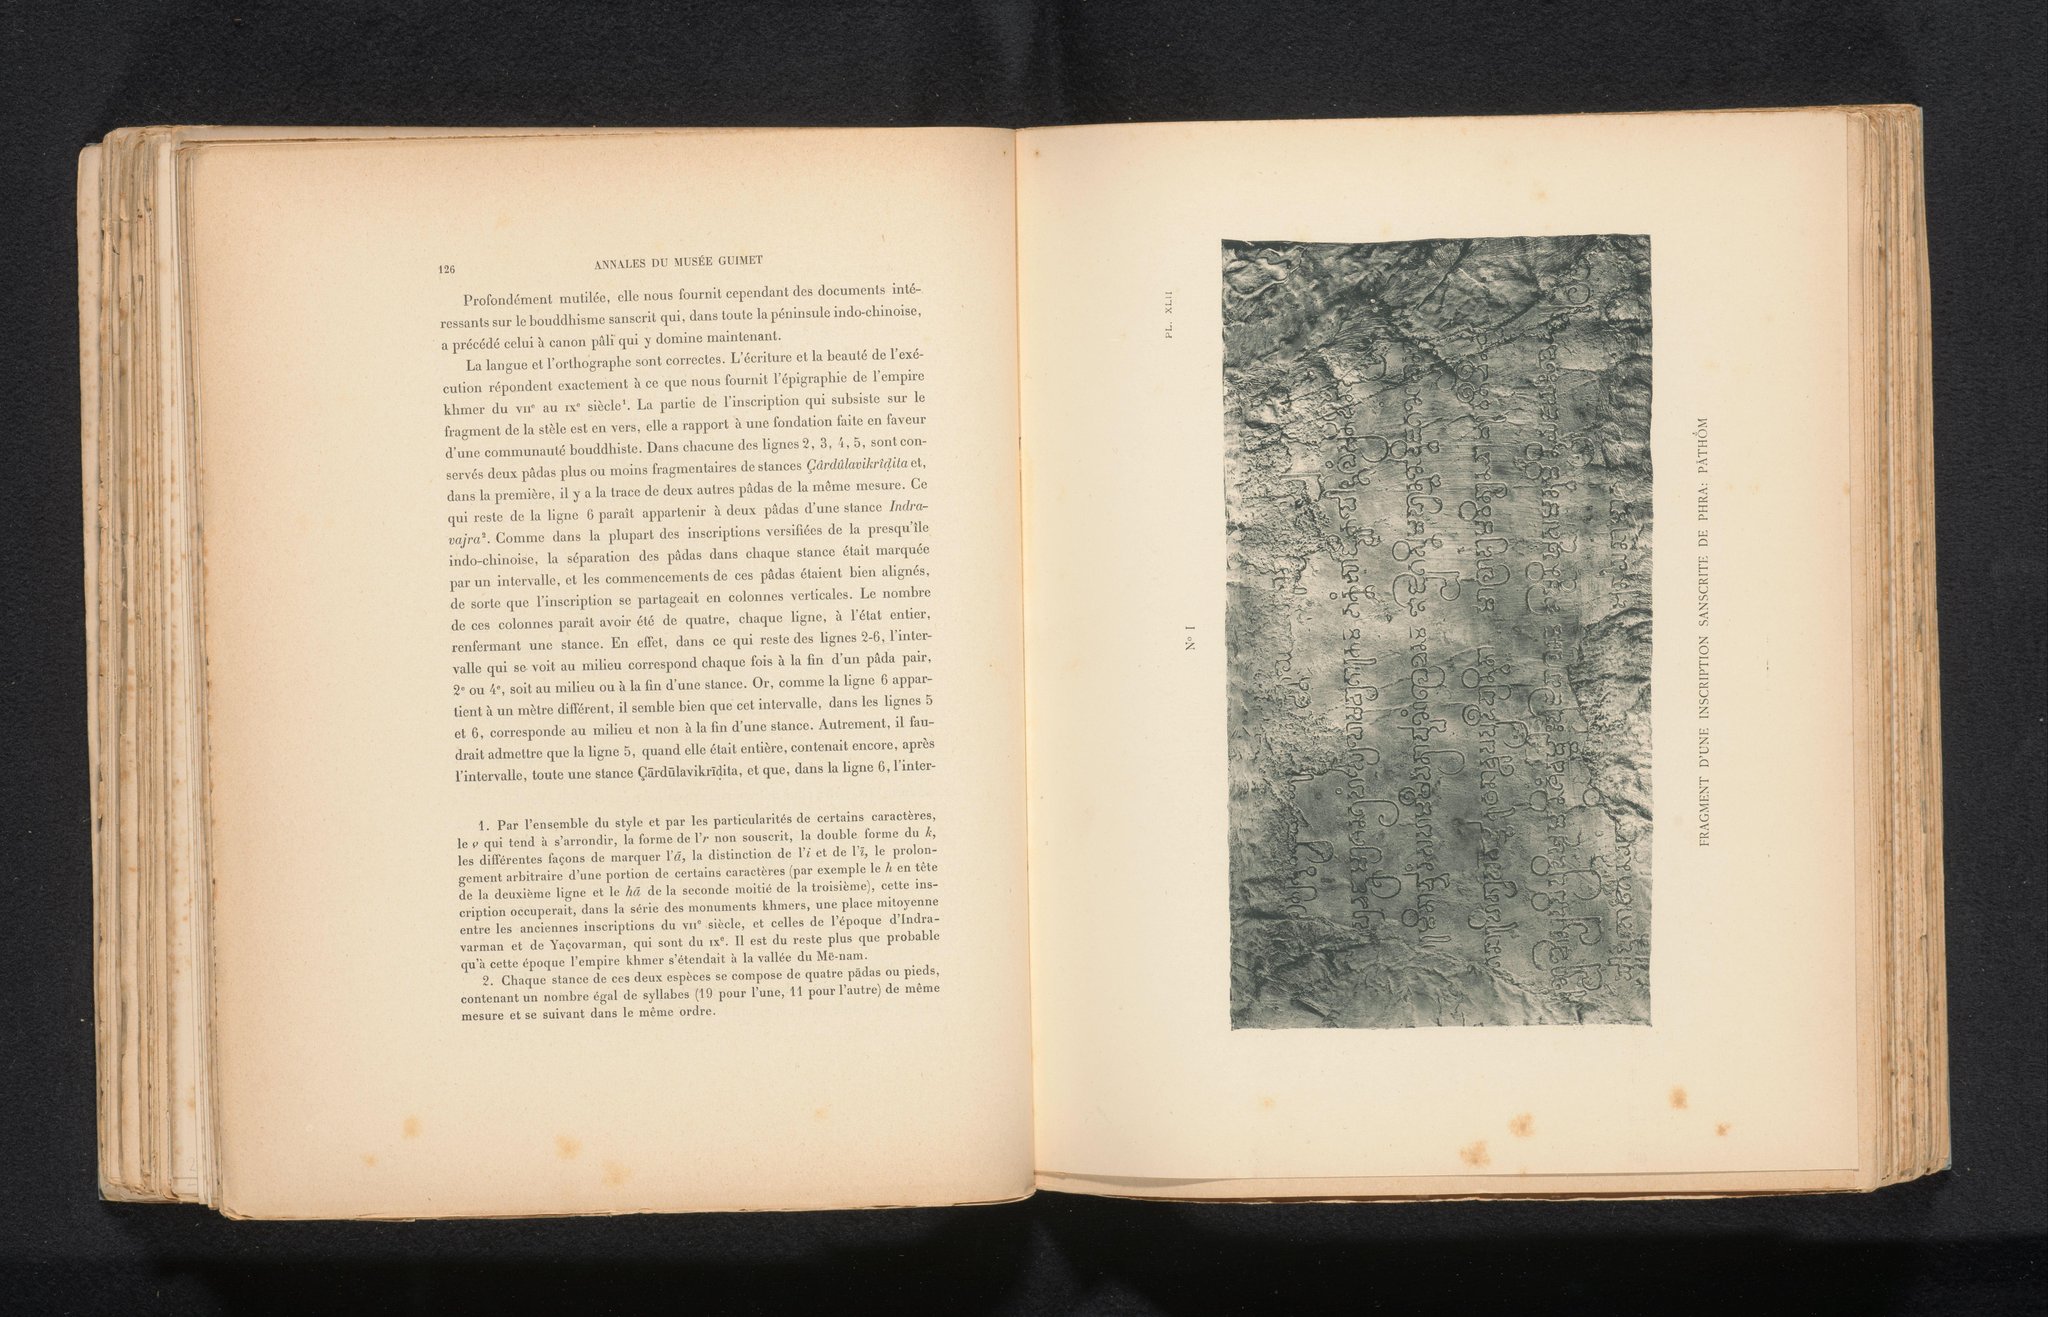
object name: page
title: Fragment d'une inscription sanscrite de phra: Păthŏm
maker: Anonymous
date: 1890-1895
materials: paper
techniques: photograph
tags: inscription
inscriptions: inscription: ‘Pl. XLII’, collector's mark: ‘Société d'Emulation de l'Ain/ Bourg/ Bibliothèque’